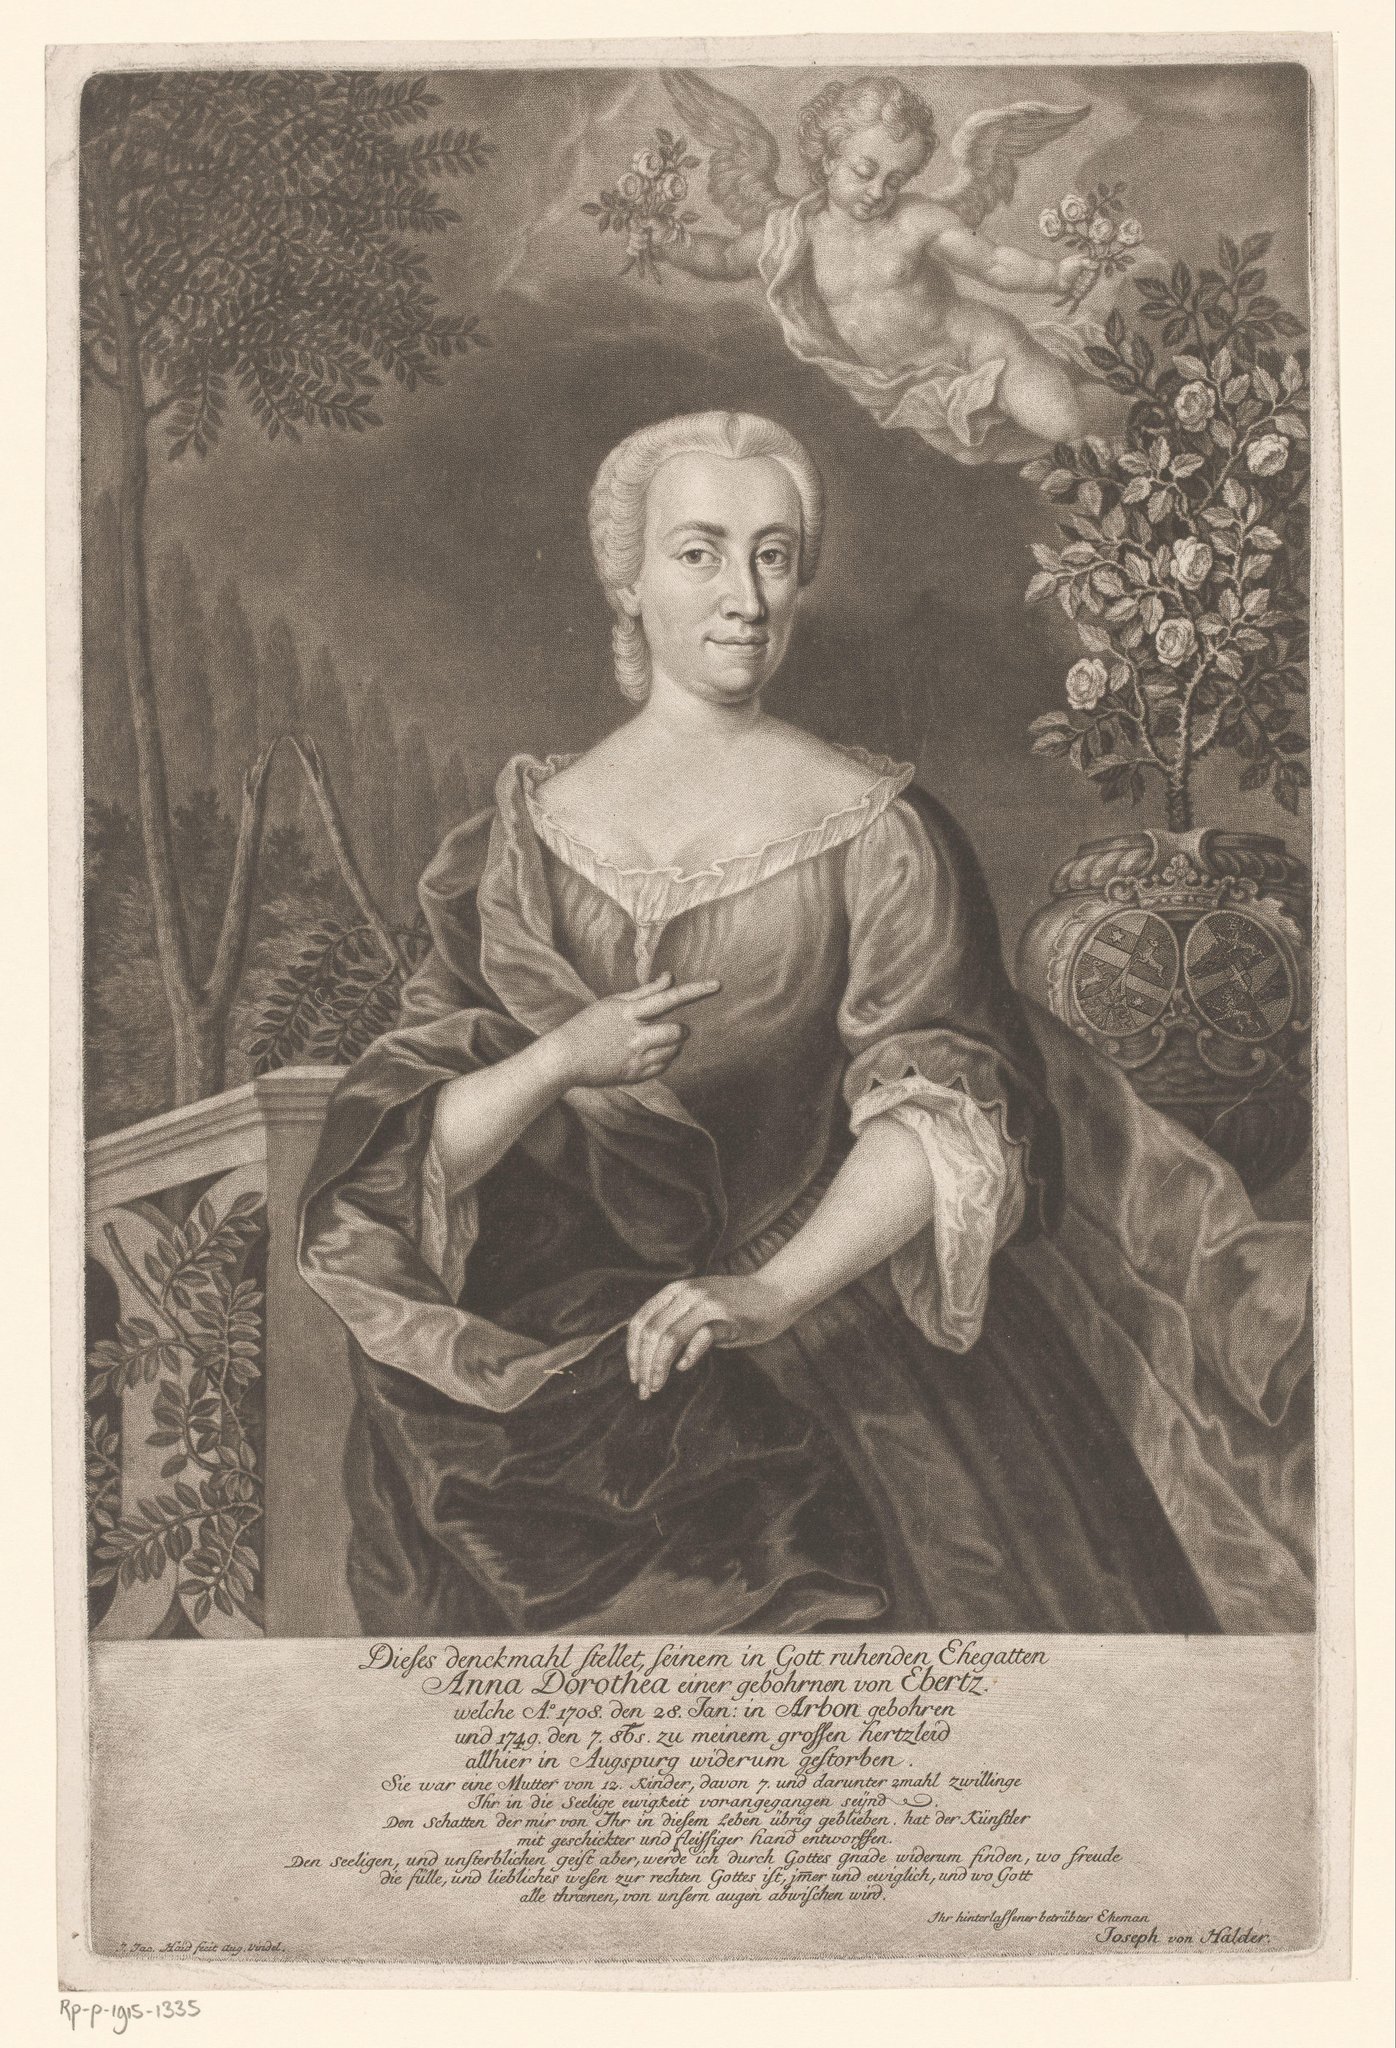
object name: print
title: Portret van Anna Dorothea von Halder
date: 1749-1757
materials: paper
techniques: etching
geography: augsburg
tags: trees (+ branch, stick), historical persons - bb - woman, shrubs: rose-bush, angels, armorial bearing, heraldry